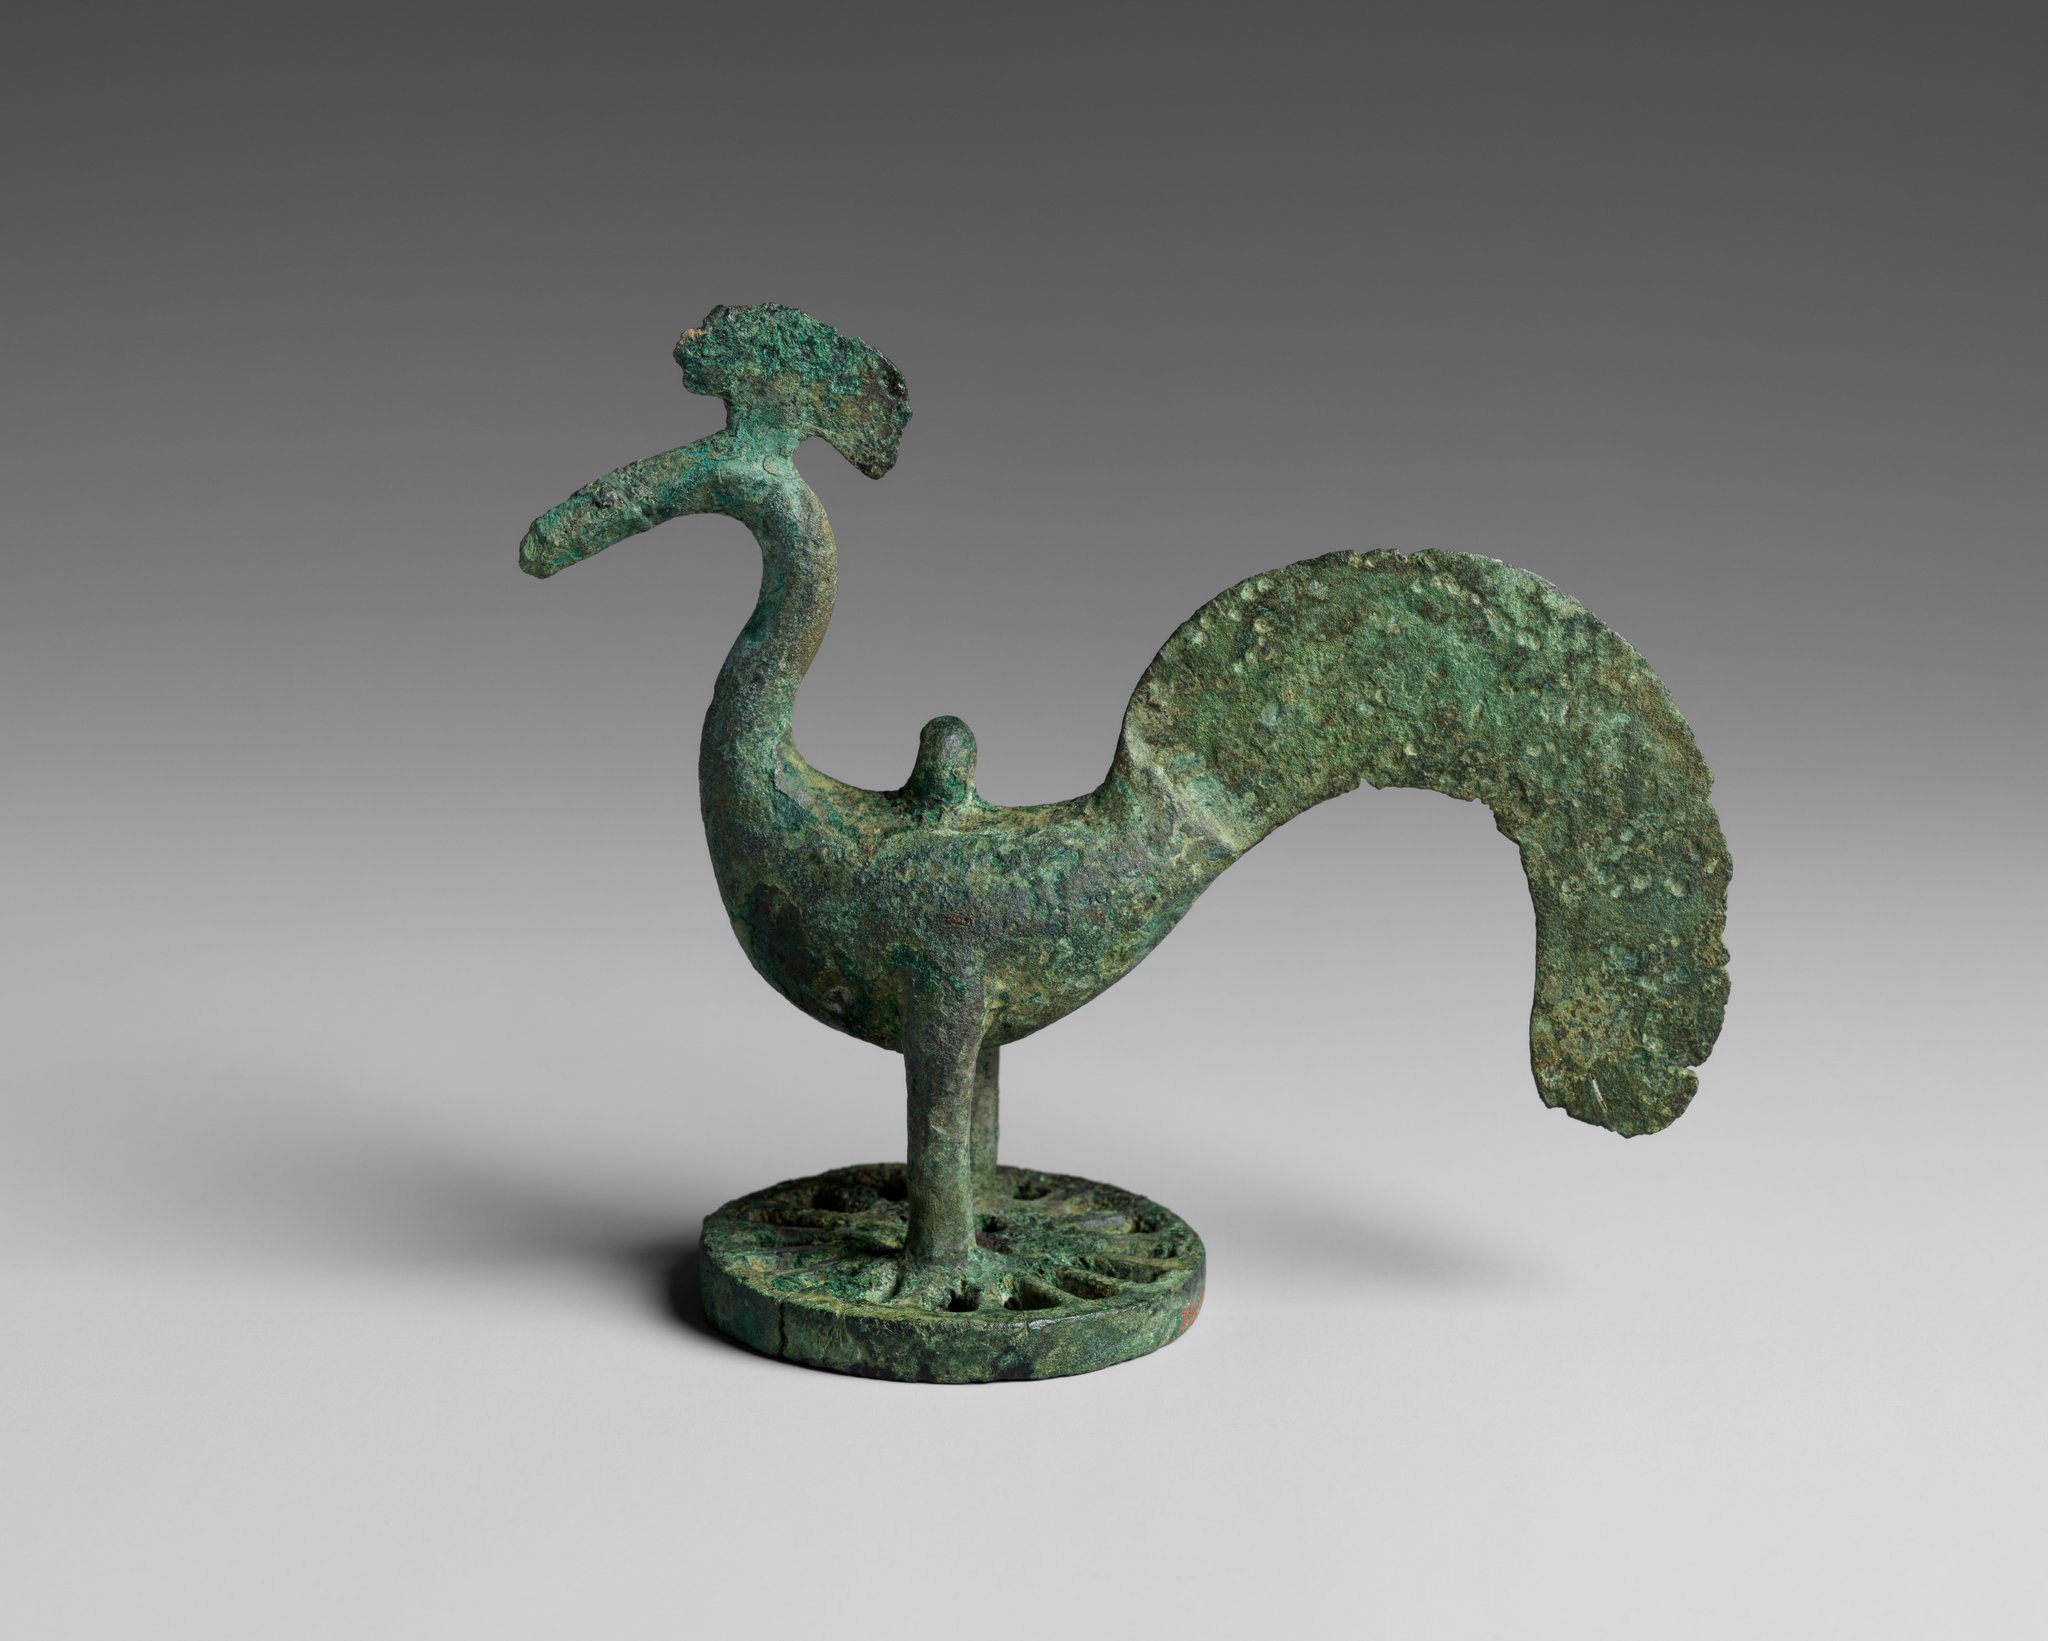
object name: statuette of a bird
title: Bronze bird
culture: greek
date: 750-700 BCE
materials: bronze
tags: birds